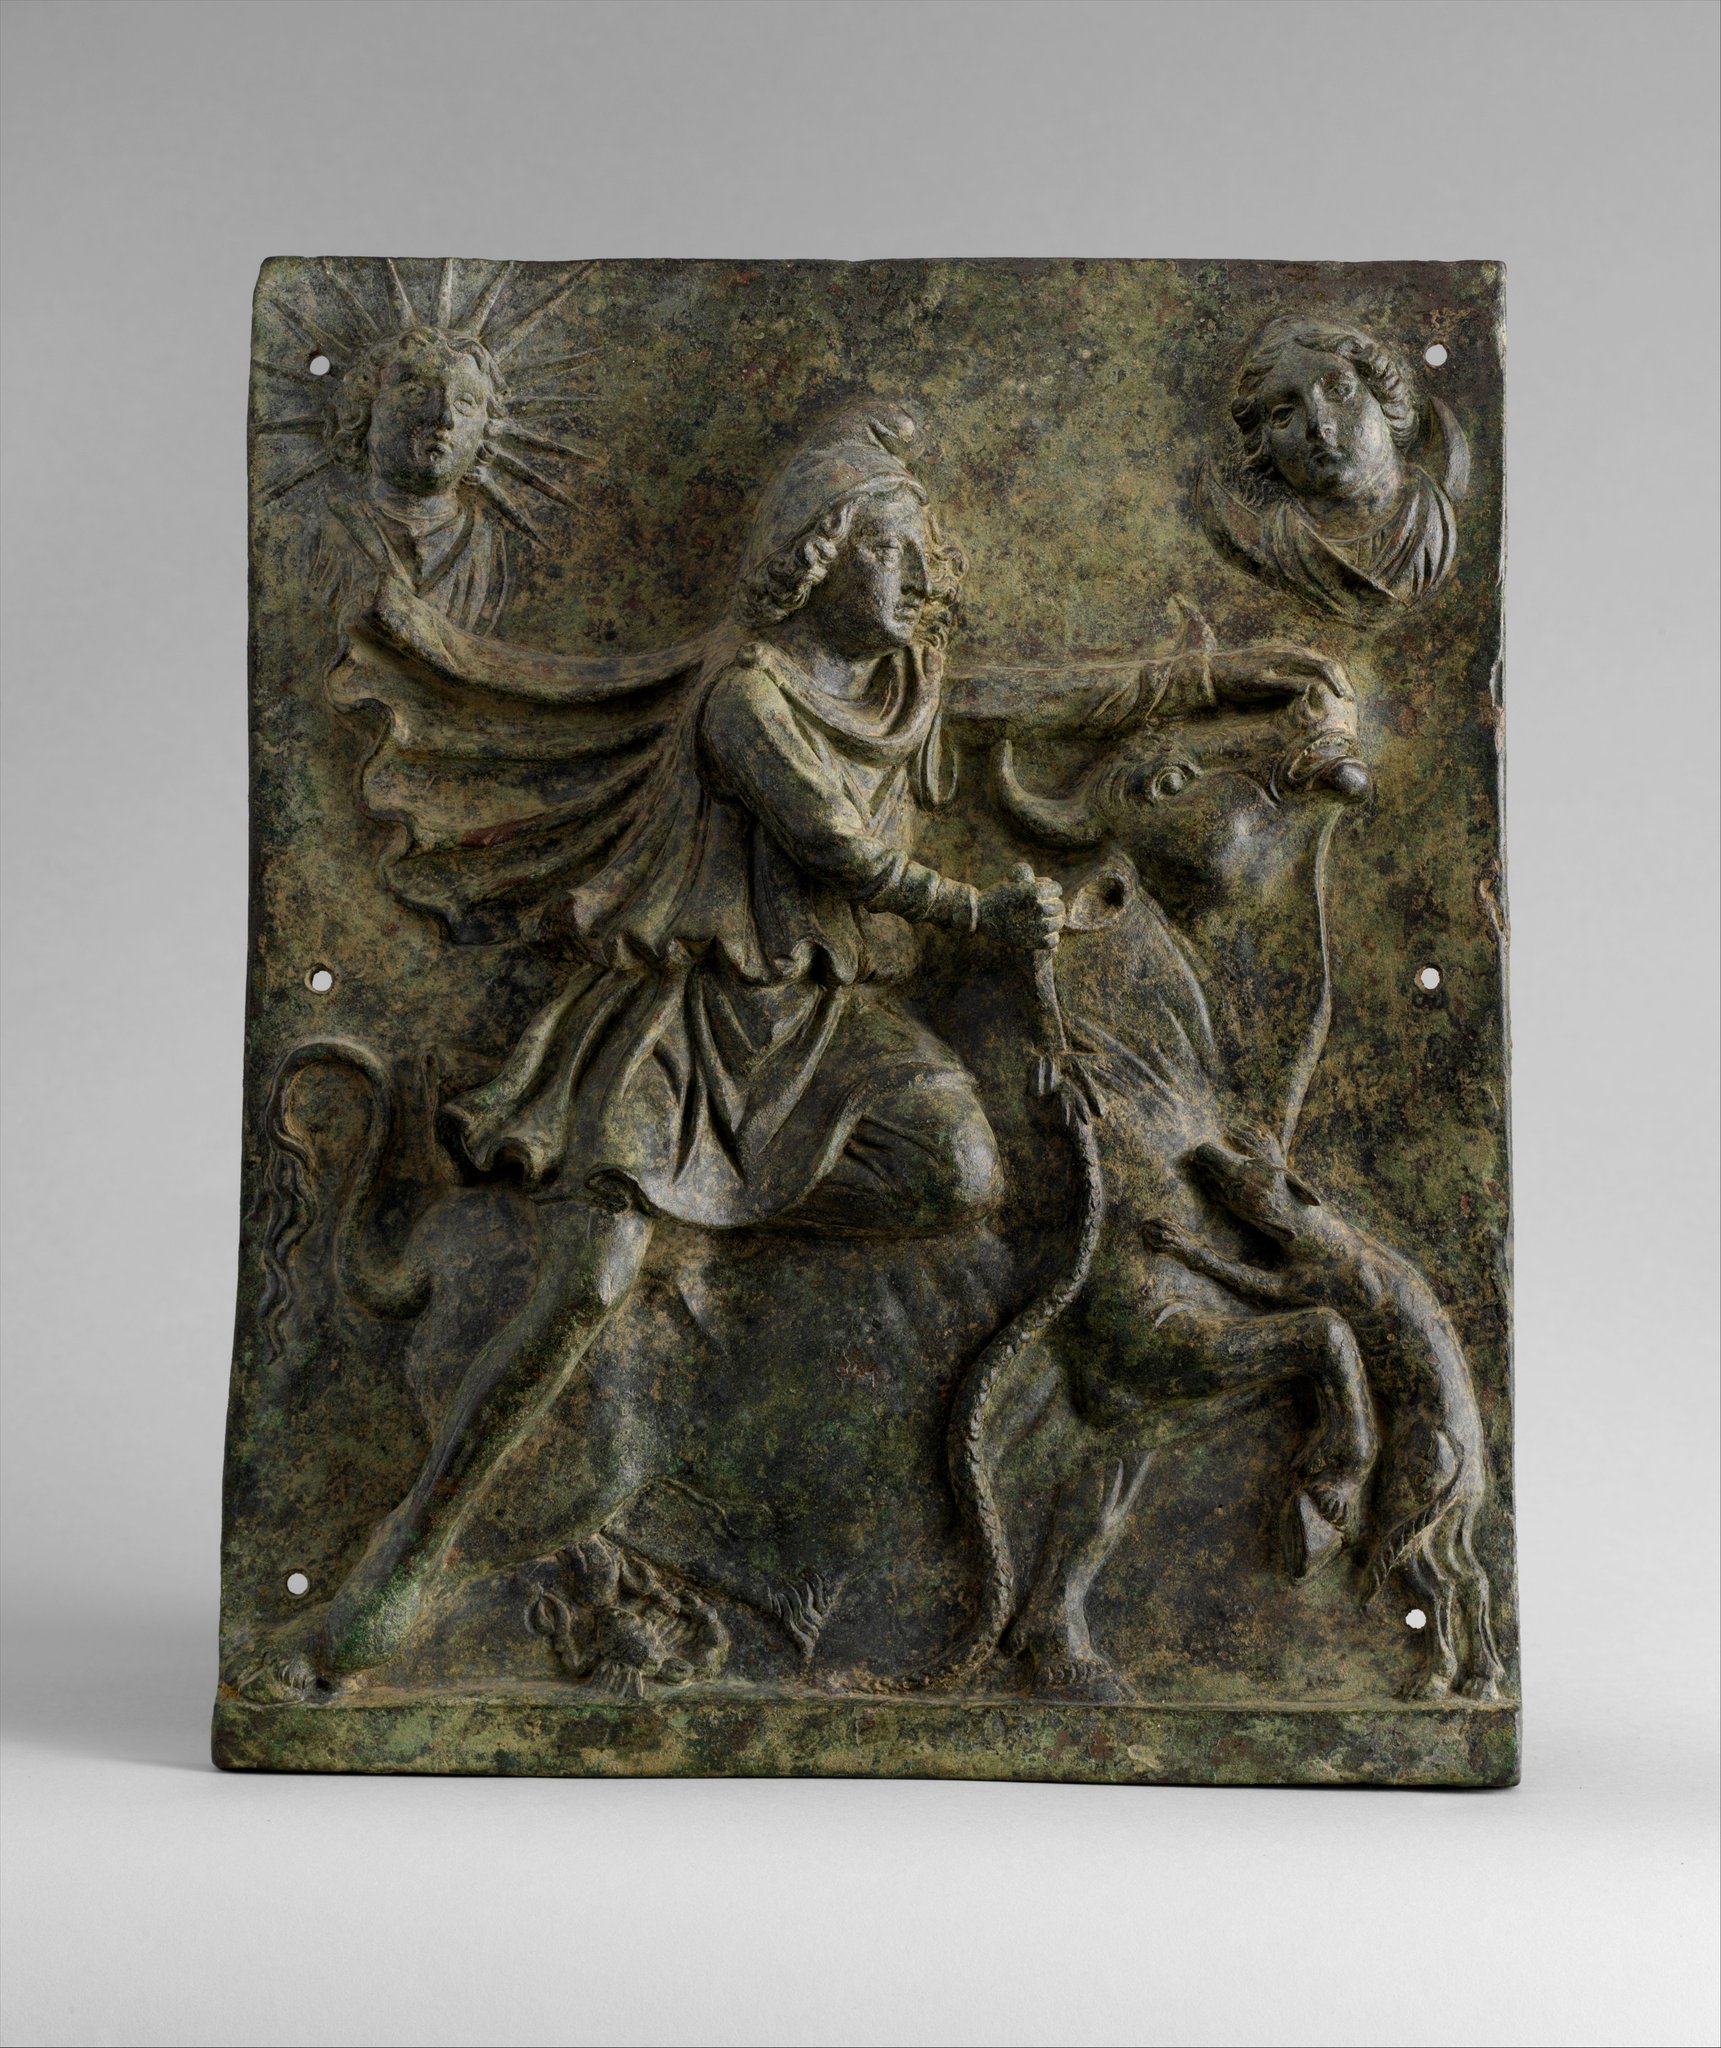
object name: plaque of mithra killing the bull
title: Bronze plaque of Mithras slaying the bull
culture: roman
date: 134-233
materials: bronze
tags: men,bulls,dogs,scorpions,snakes